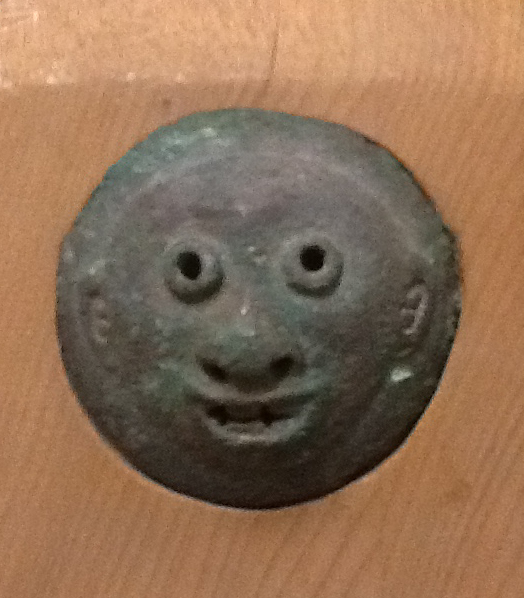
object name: plaque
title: Plaque with Anthropomorphic Face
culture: chinese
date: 1100-901 BCE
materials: bronze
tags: faces